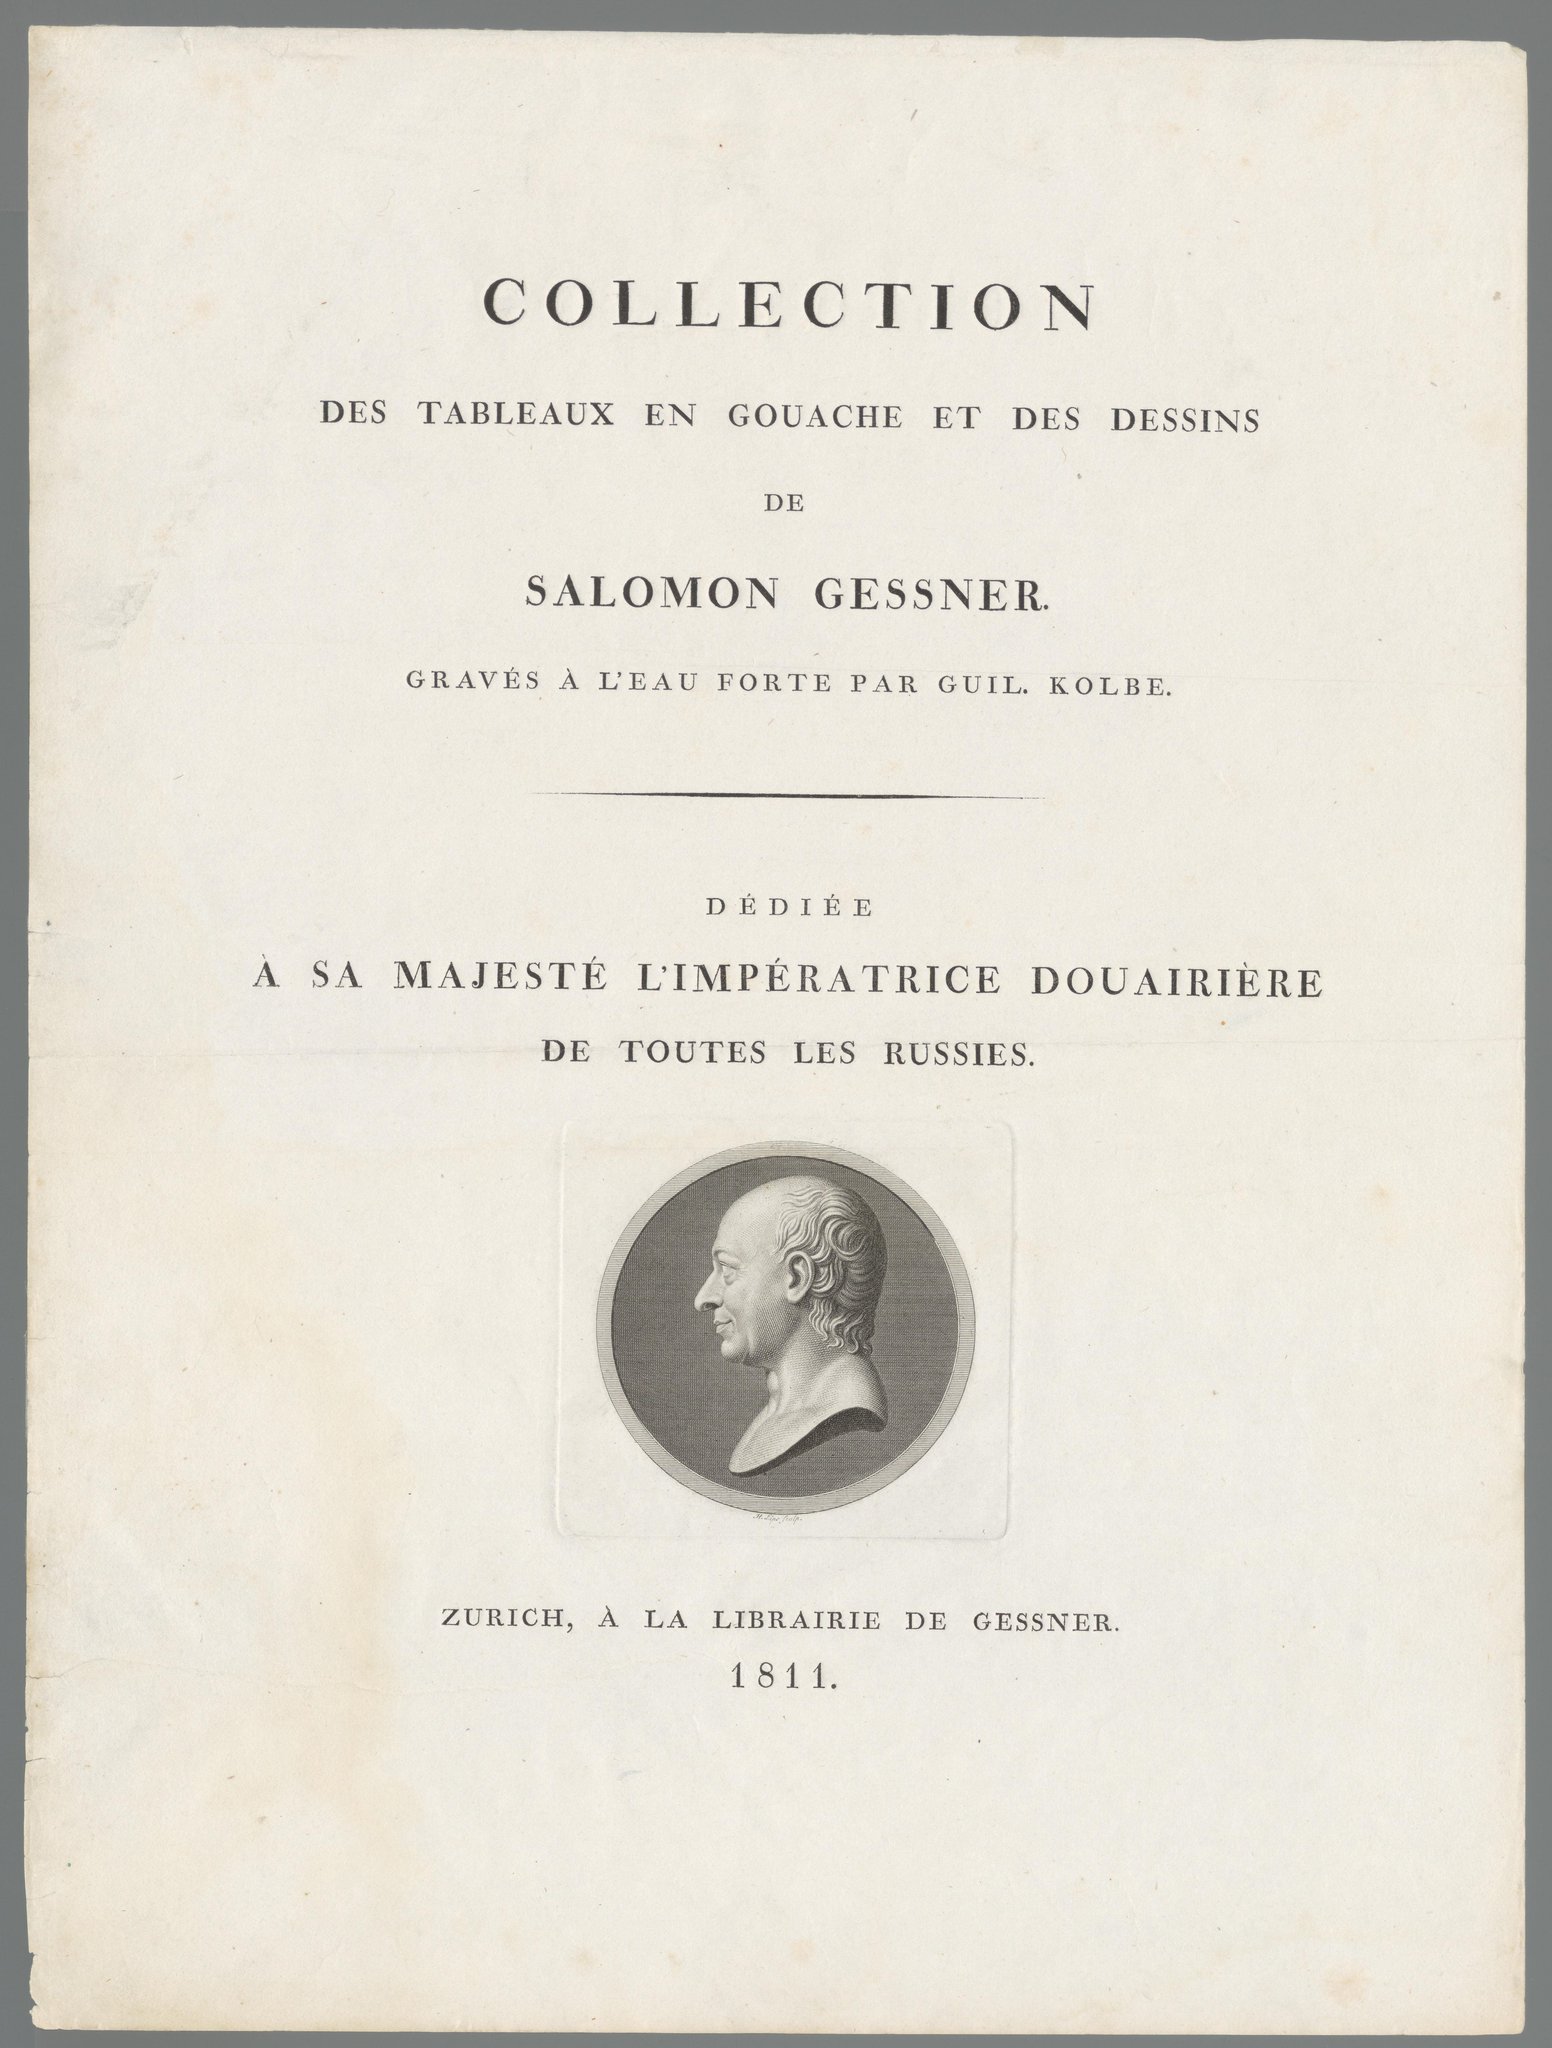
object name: print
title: Portret van Salomon Gessner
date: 1811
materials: paper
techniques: engraving, letterpress printing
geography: zurich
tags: painter, print maker, salomon gessner, historical persons, title-page, portrait, self-portrait of draughtsman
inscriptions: date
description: Deze prent is gemaakt voor een serie uit 1811 getiteld: Collection des tableaux en gouache et des dessins de Salomon Gessner. Gravés à l'eau forte par Guil. Kolbe. De gehele serie is in het bezit van het RMA onder inv. nr. RP-P-2005-184.